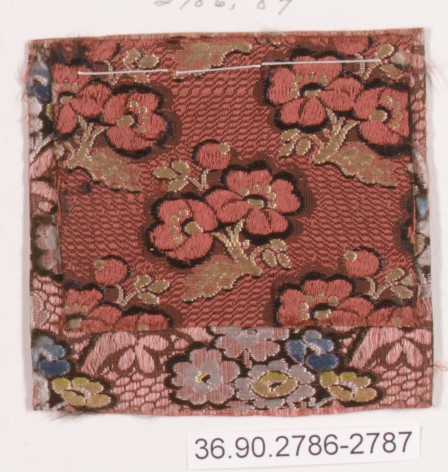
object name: piece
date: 1801-1900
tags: flowers,leaves